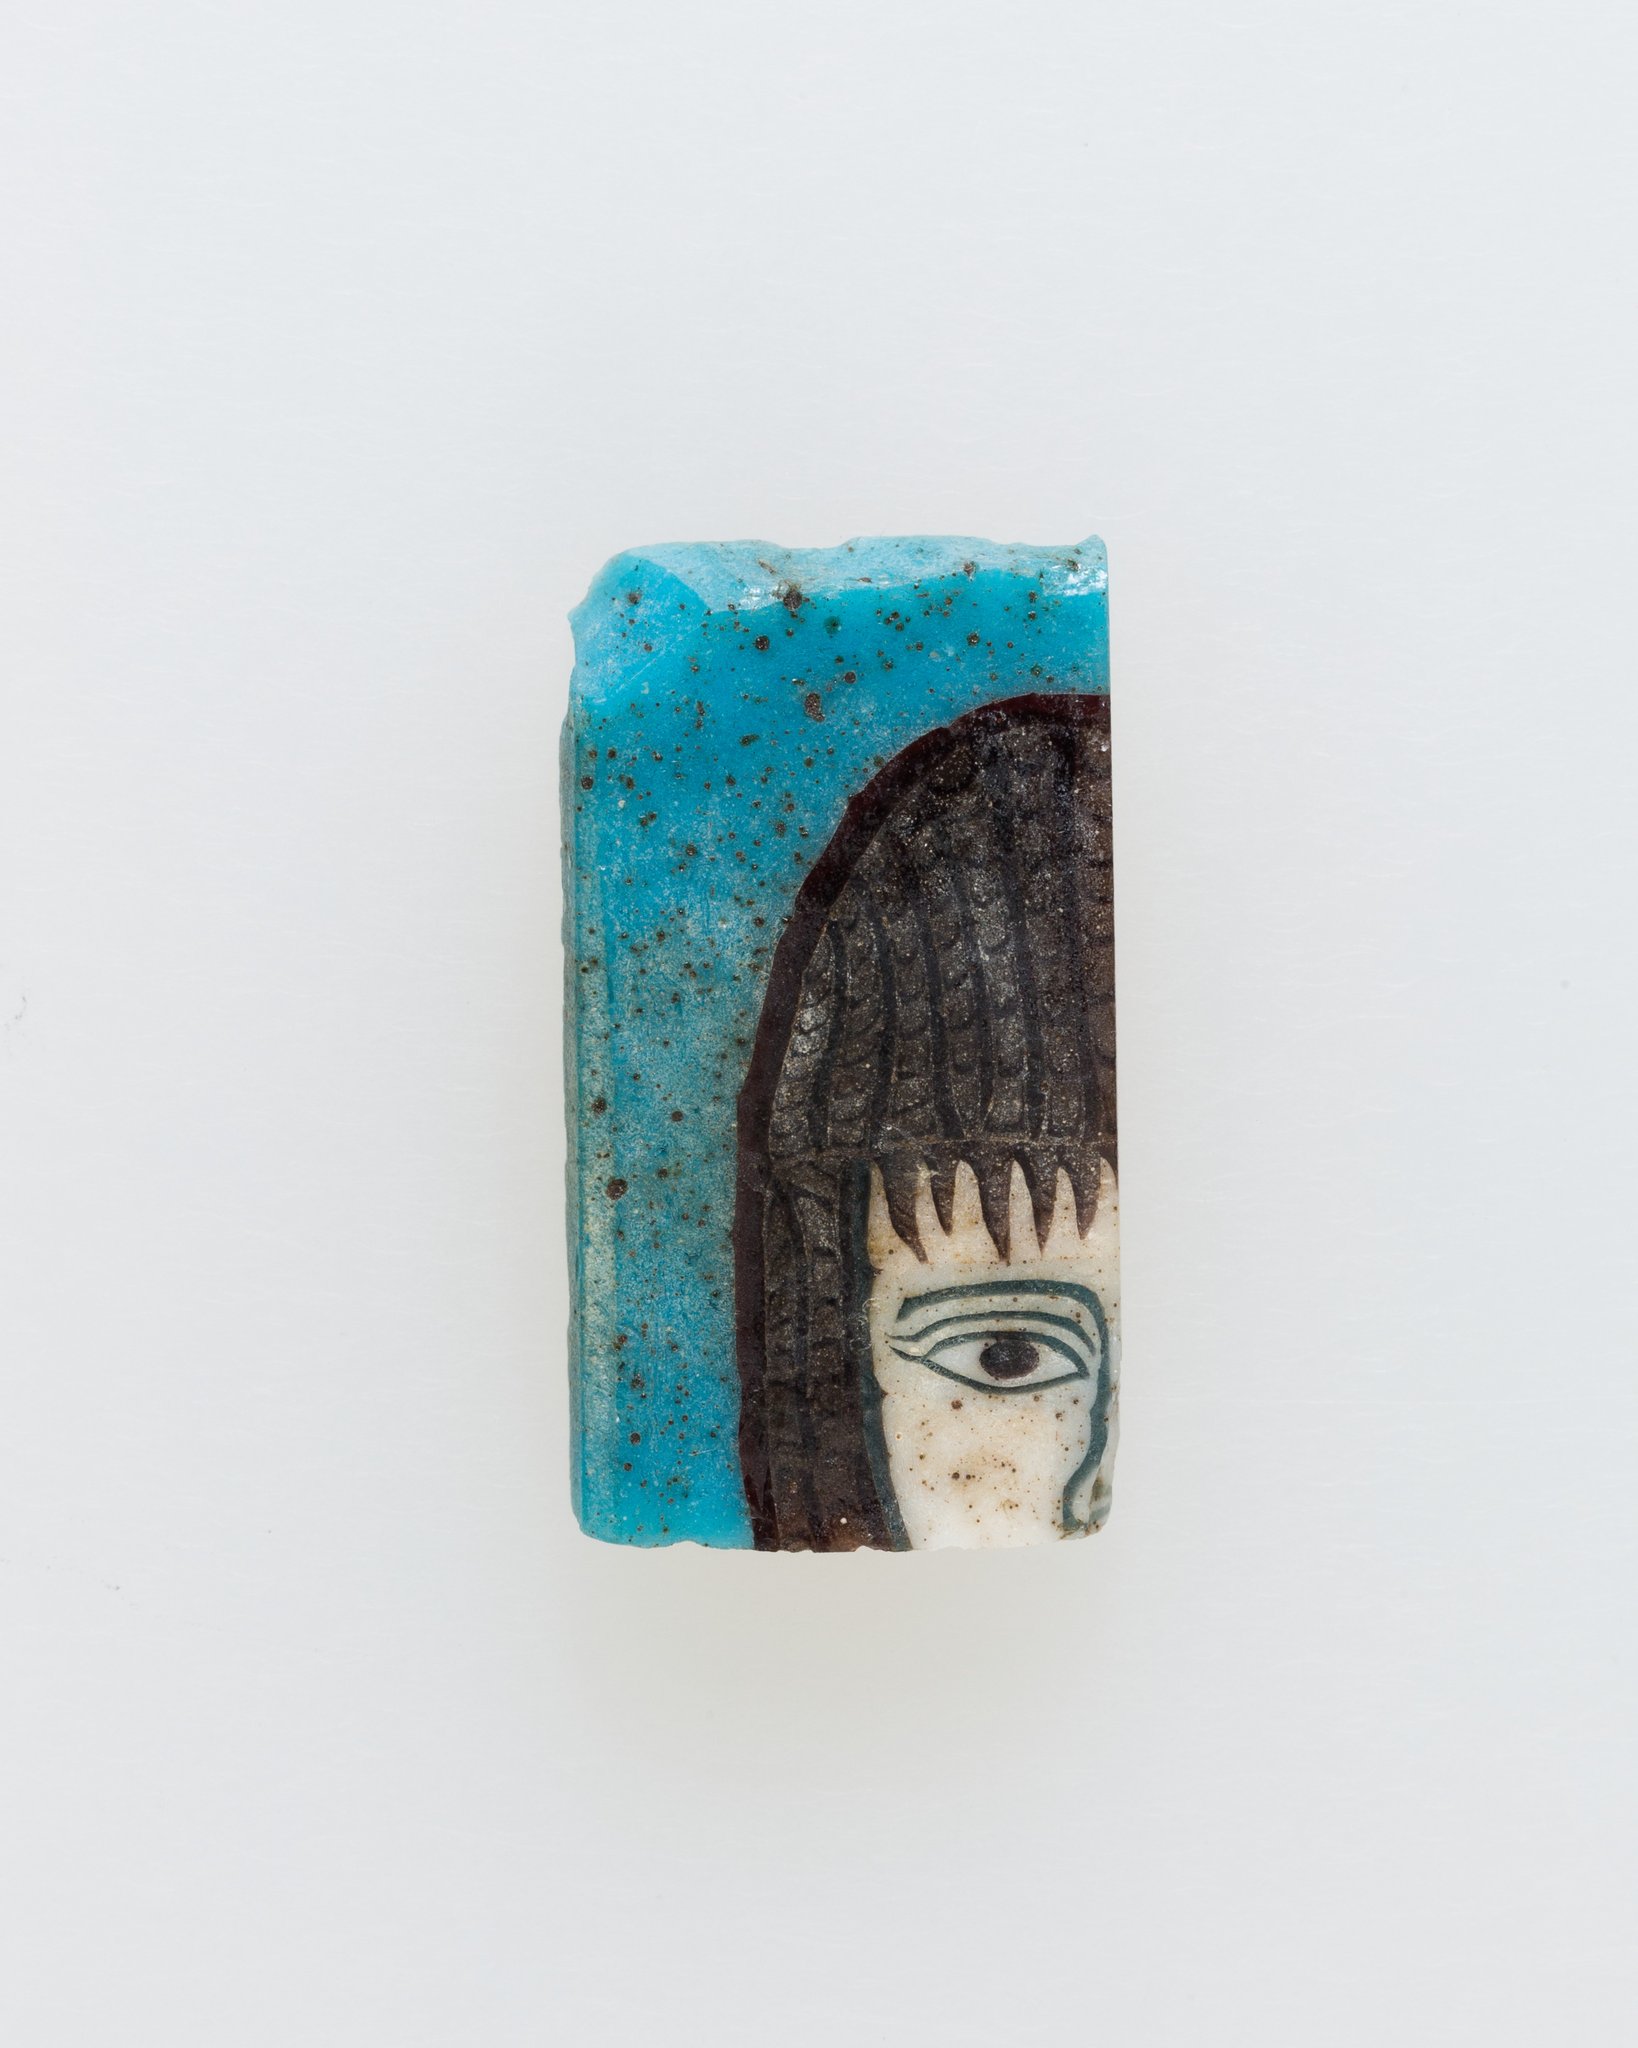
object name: inlay, head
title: Inlay, part of head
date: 100 BCE-100 CE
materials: glass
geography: egypt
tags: heads